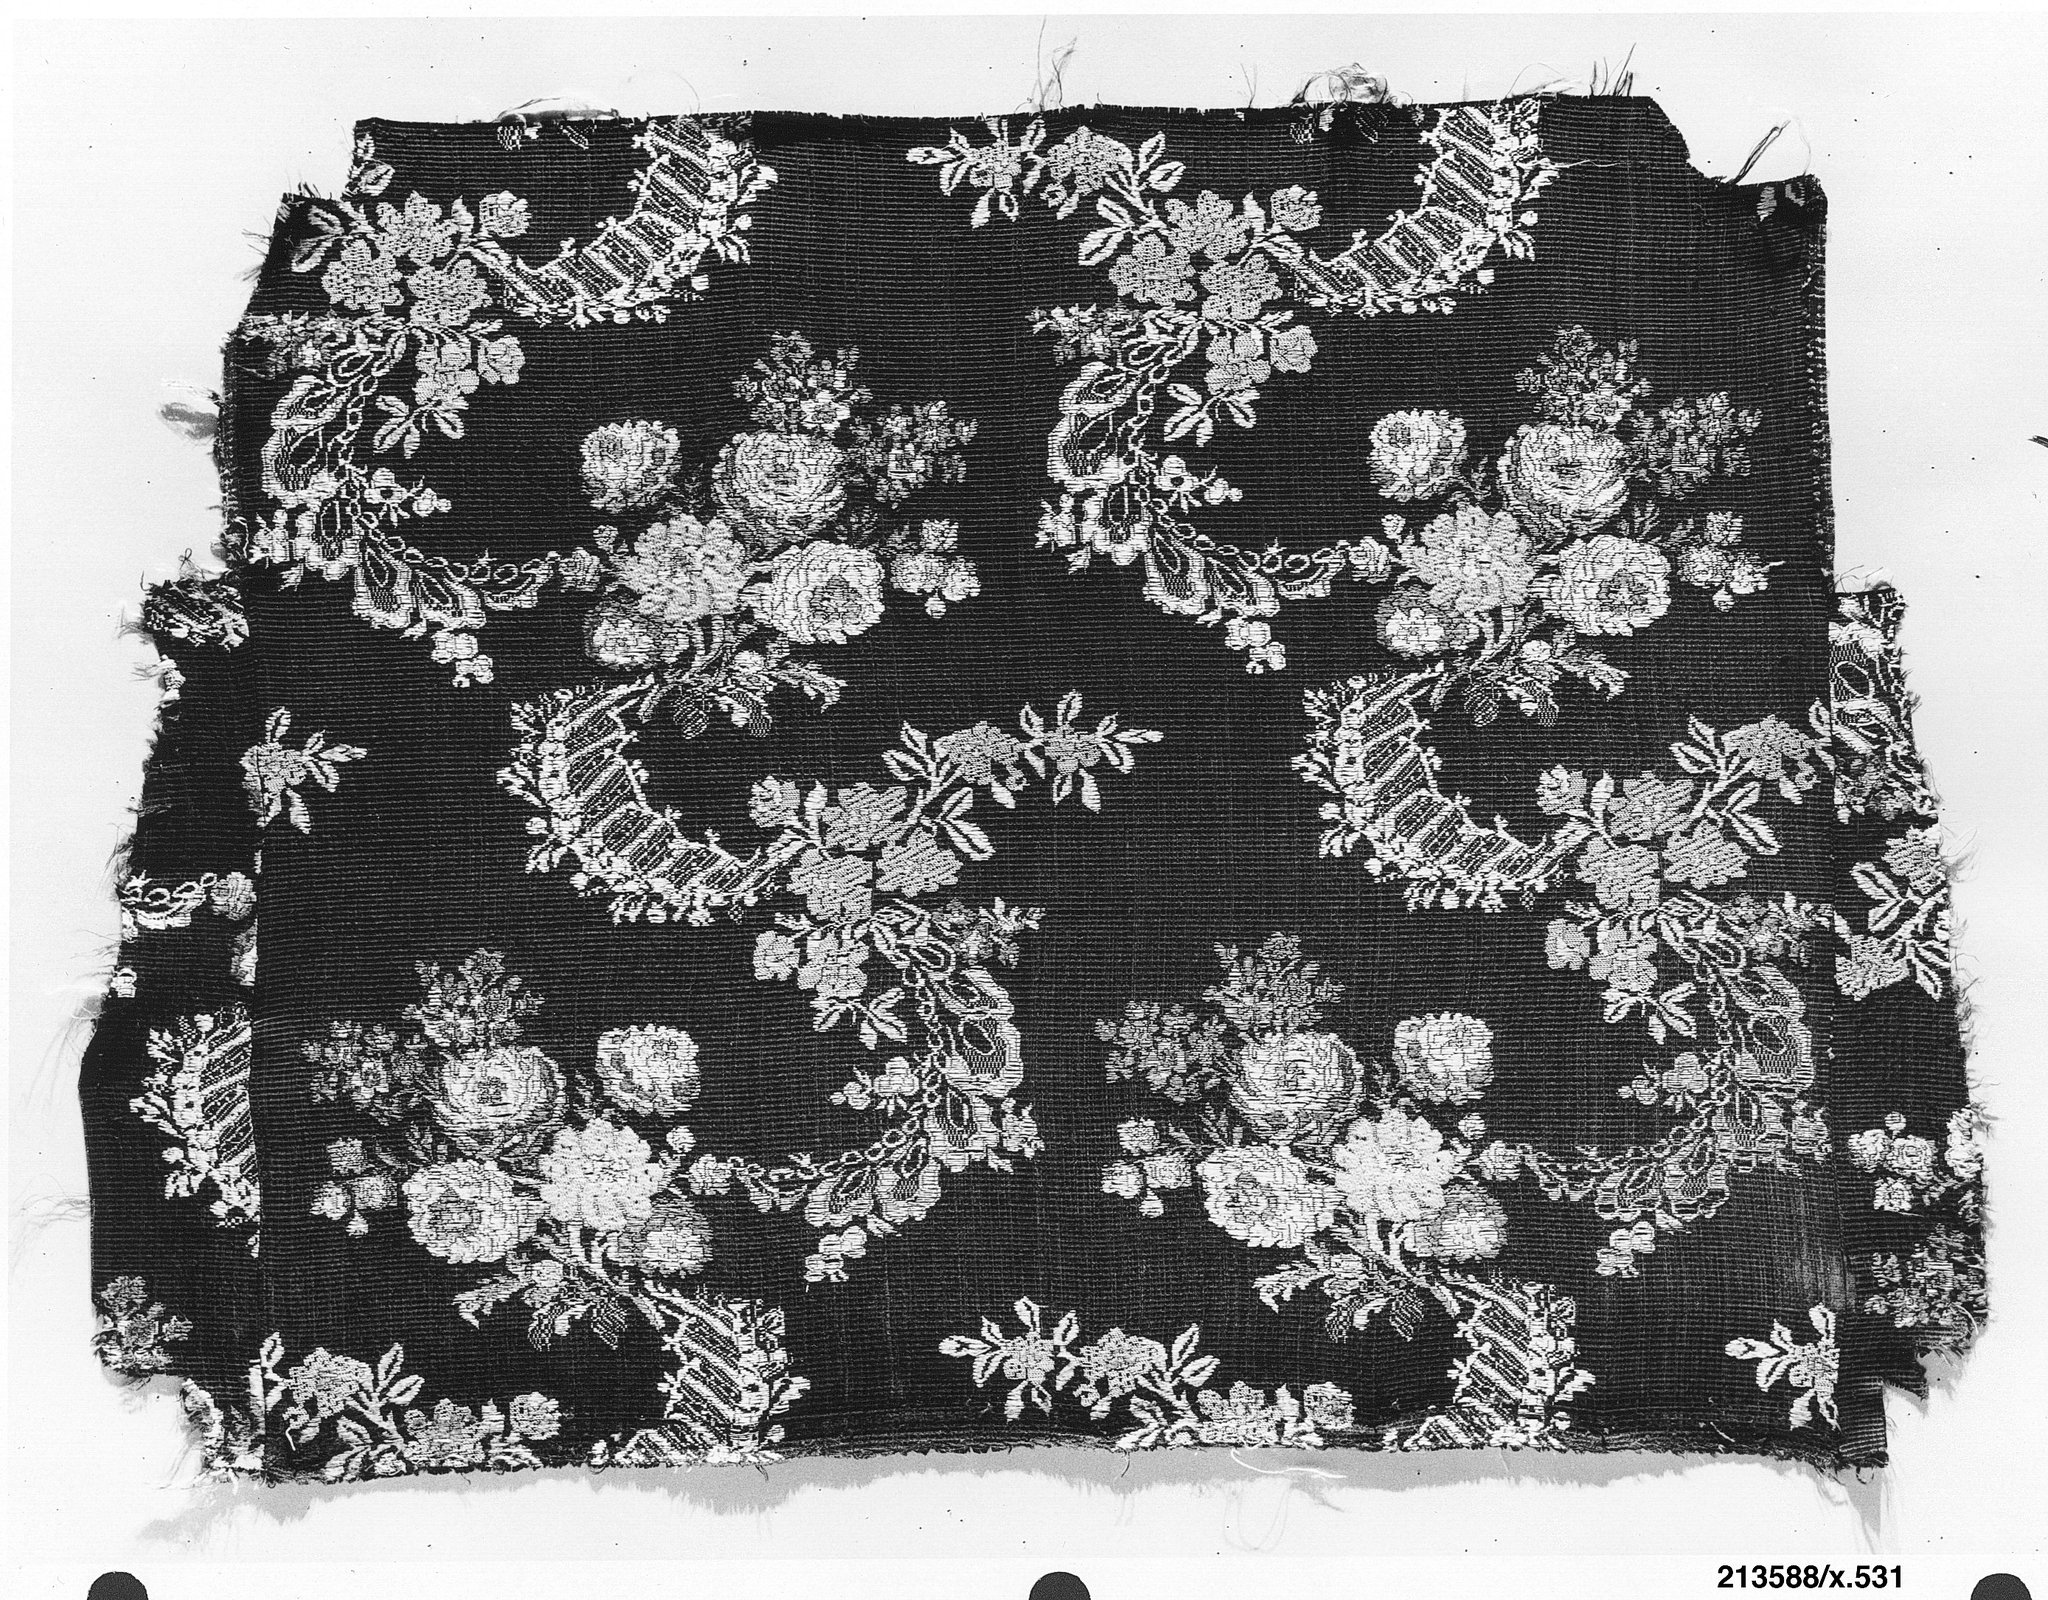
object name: upholstery panel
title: Chair seat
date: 1734-1766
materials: silk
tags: flowers